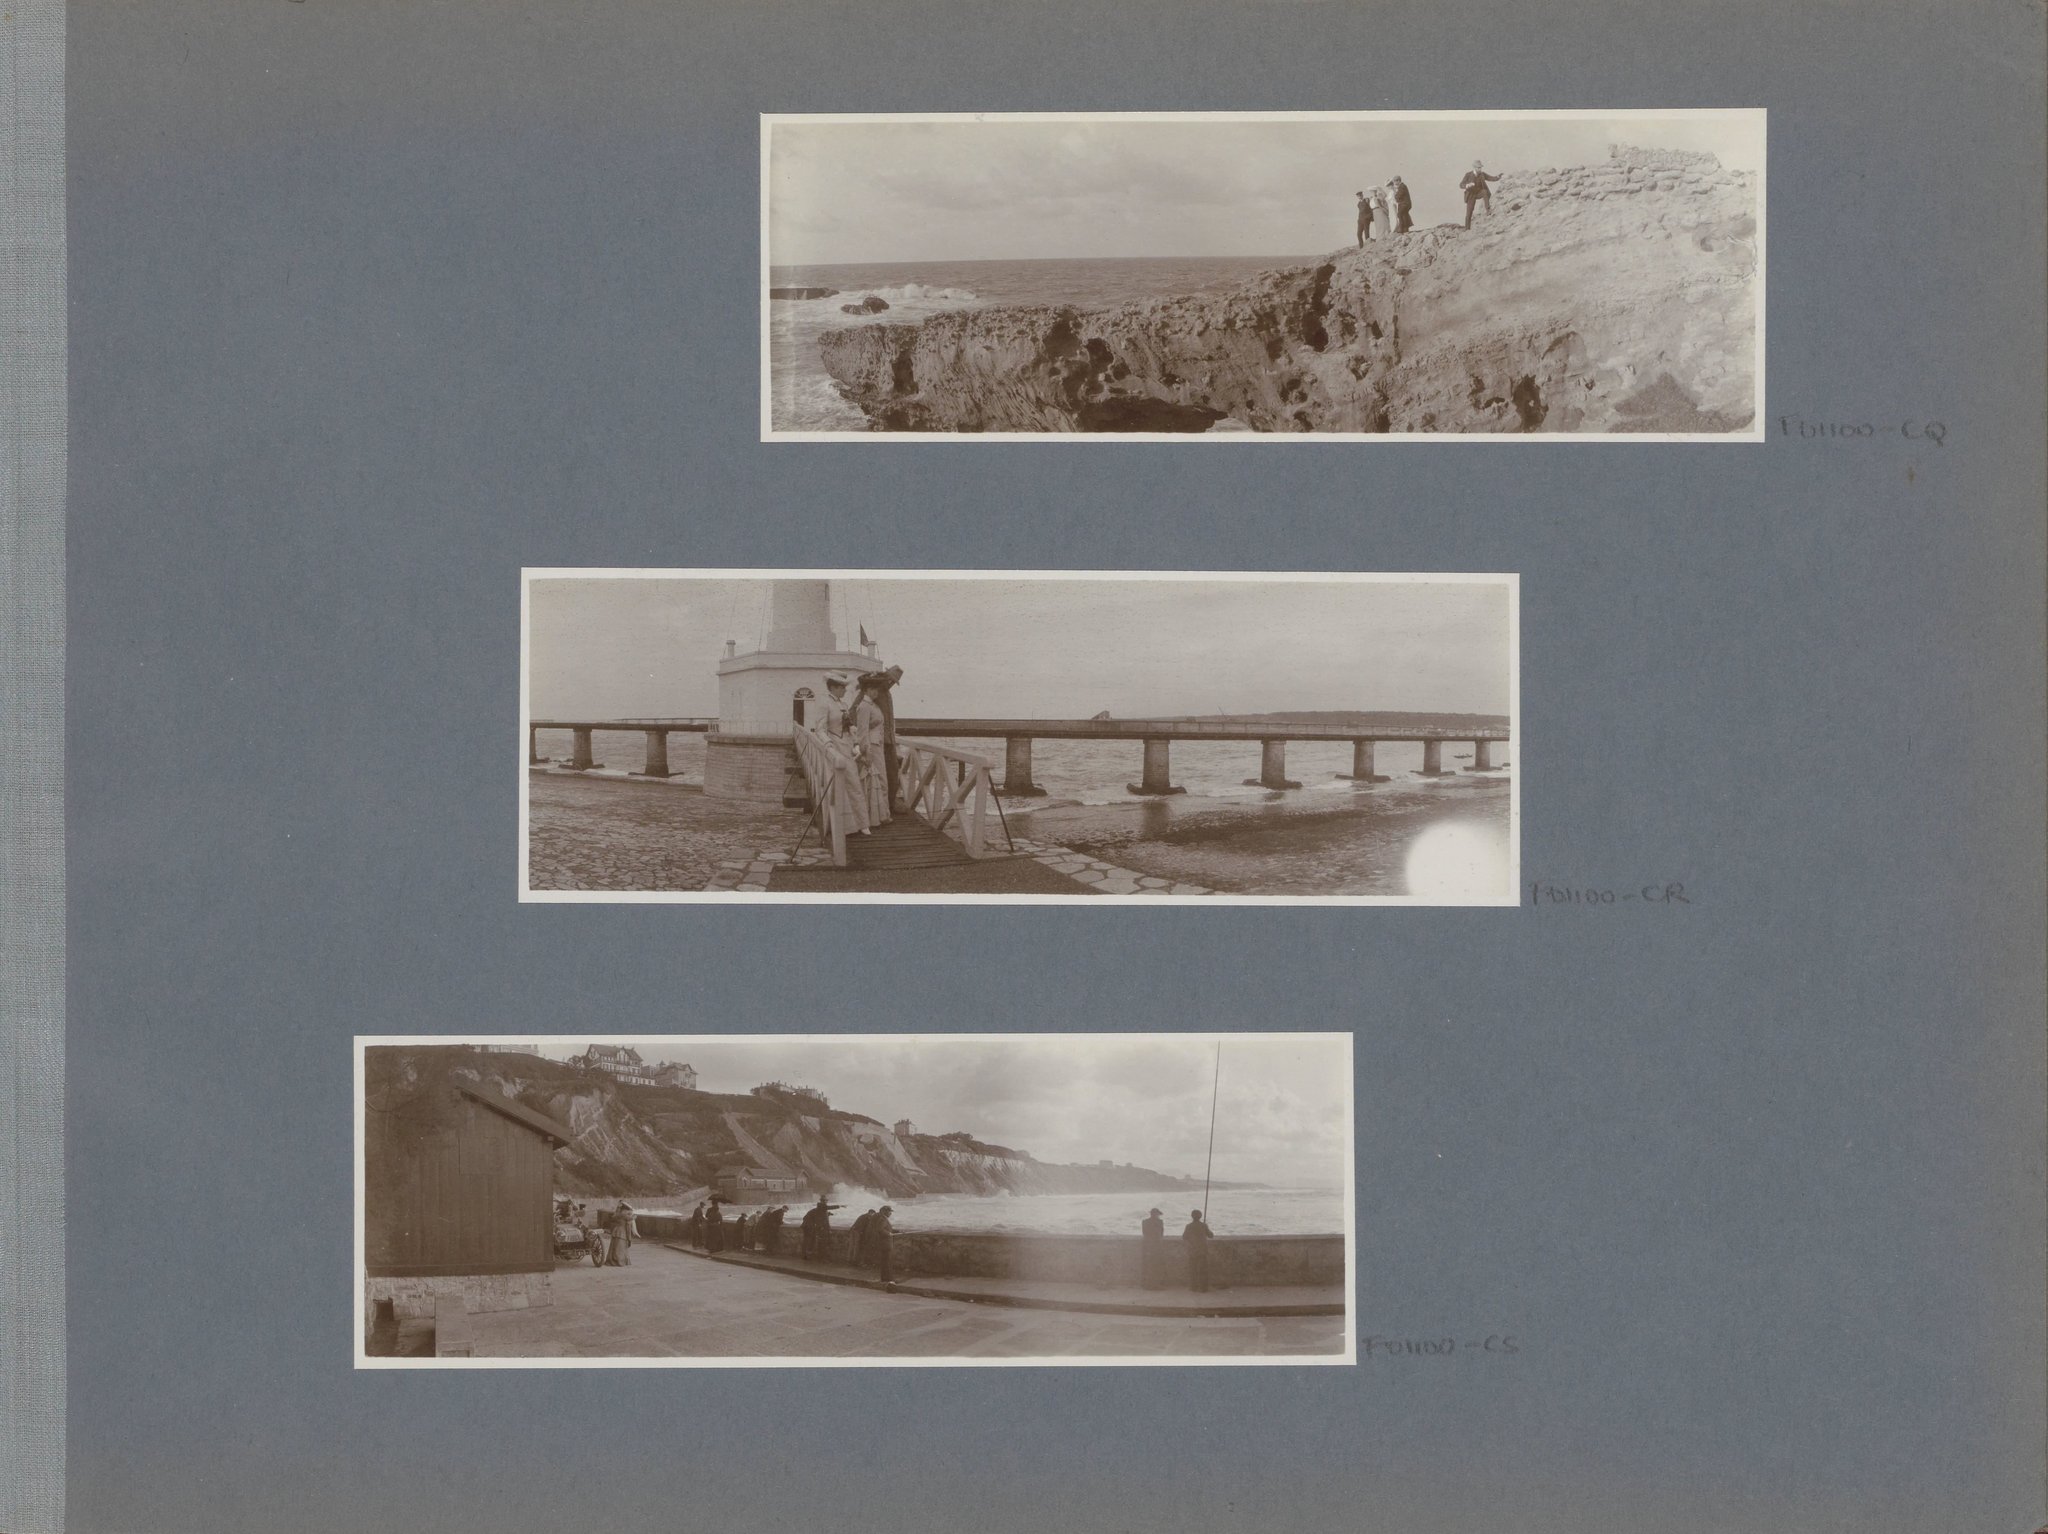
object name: photograph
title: Vier mannen en vrouwen bij een pier in zee aan de Franse kust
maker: Anonymous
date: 1902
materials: paper, photographic support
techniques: daylight paper print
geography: france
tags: pier, quay, wharf, france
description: Onderdeel van Fotoalbum van een legeroefening in Zuidwest-Frankrijk in 1902.